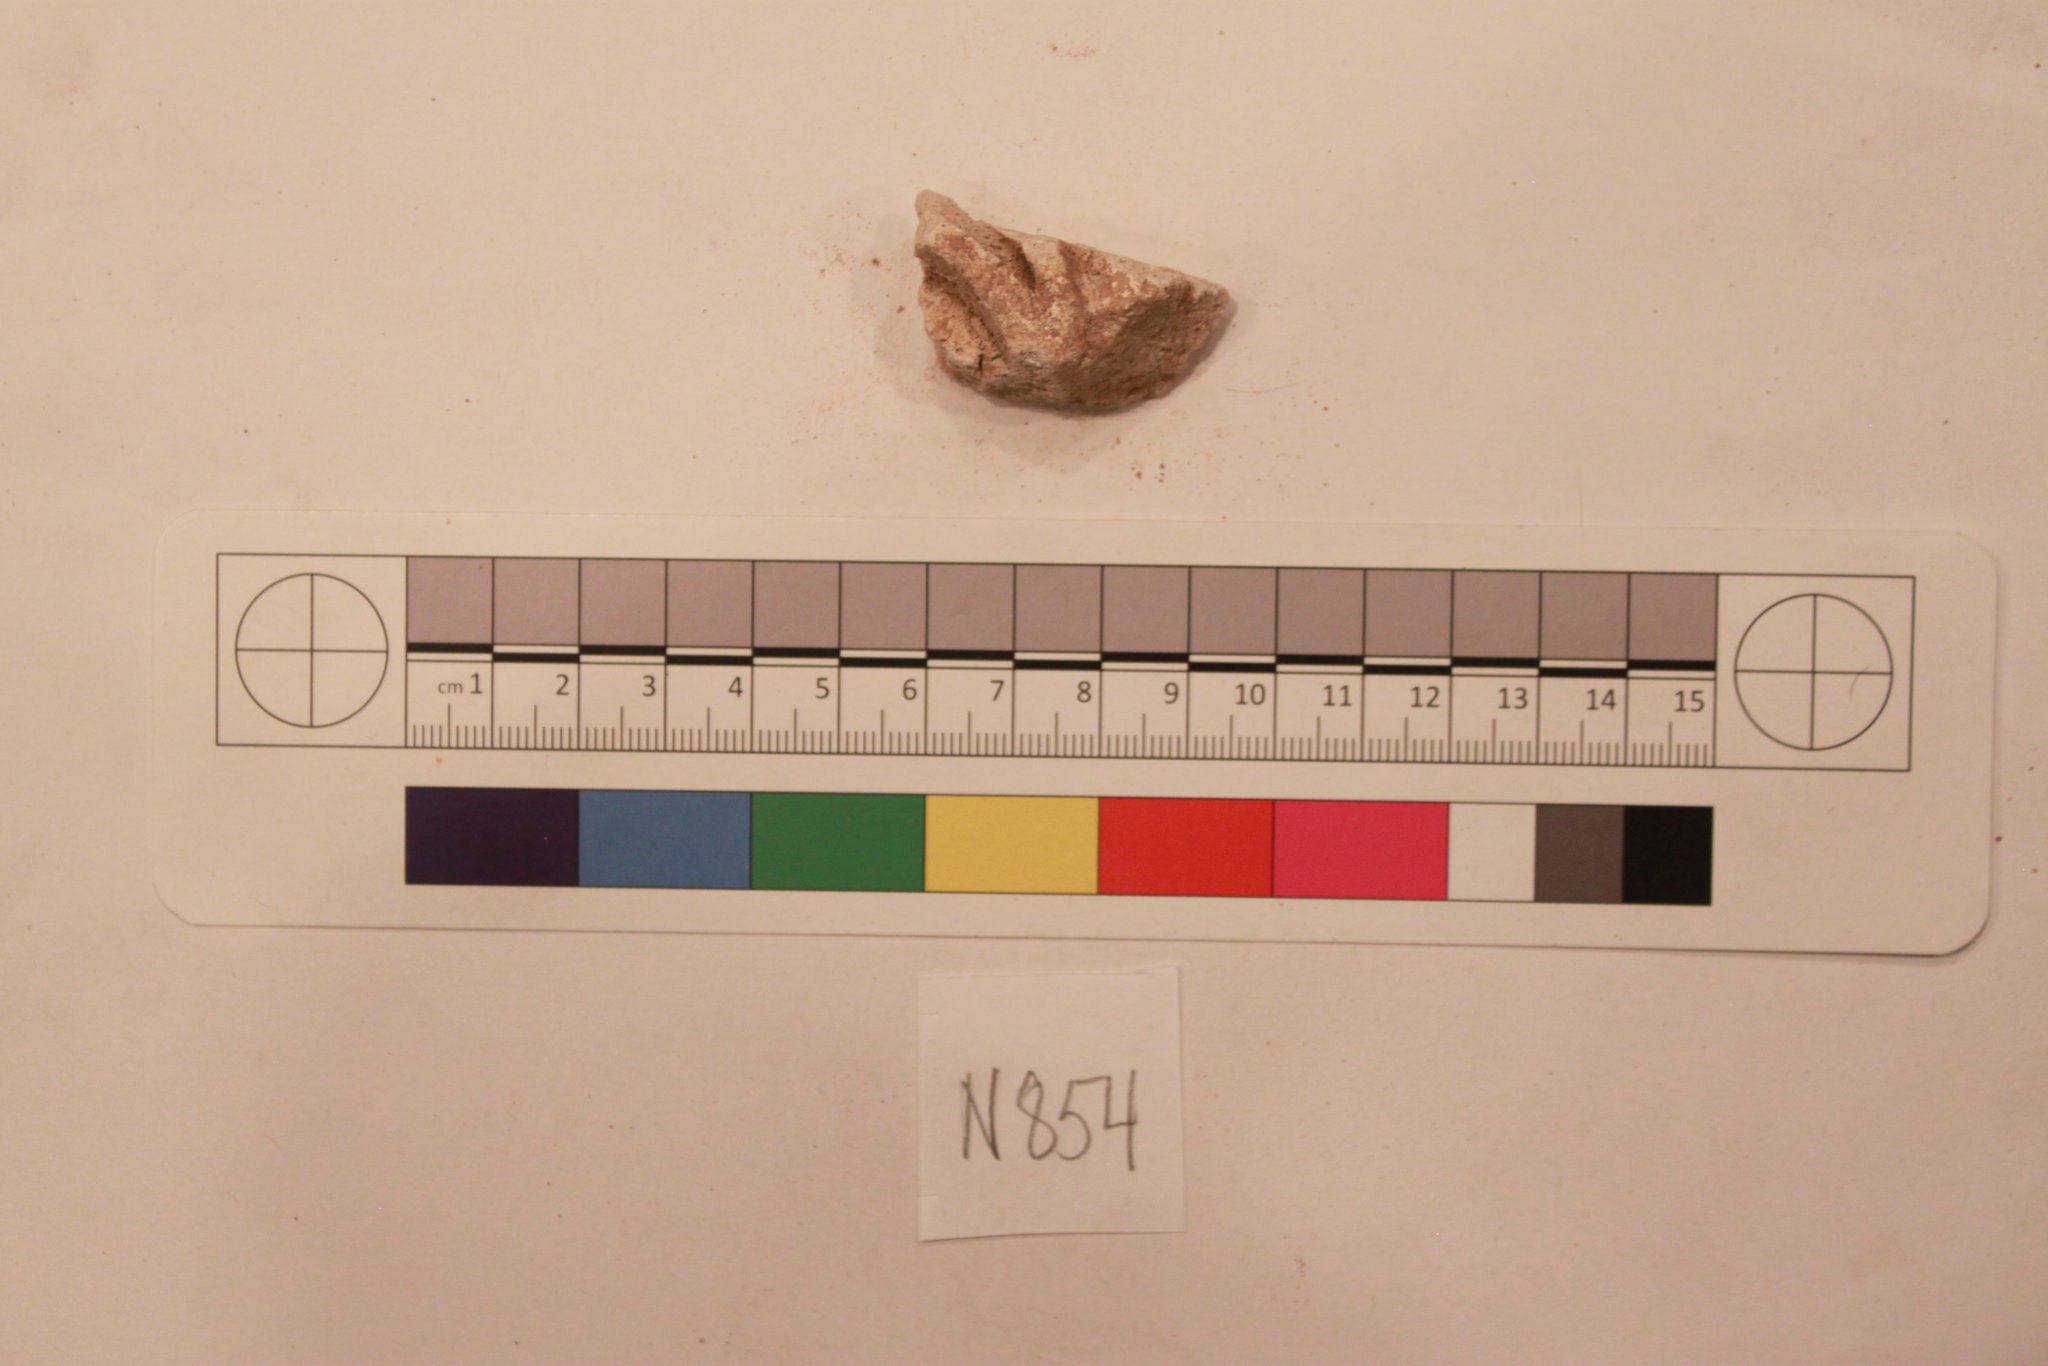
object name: fragment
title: Stucco Fragment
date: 701-1200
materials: plaster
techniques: carving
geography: iran